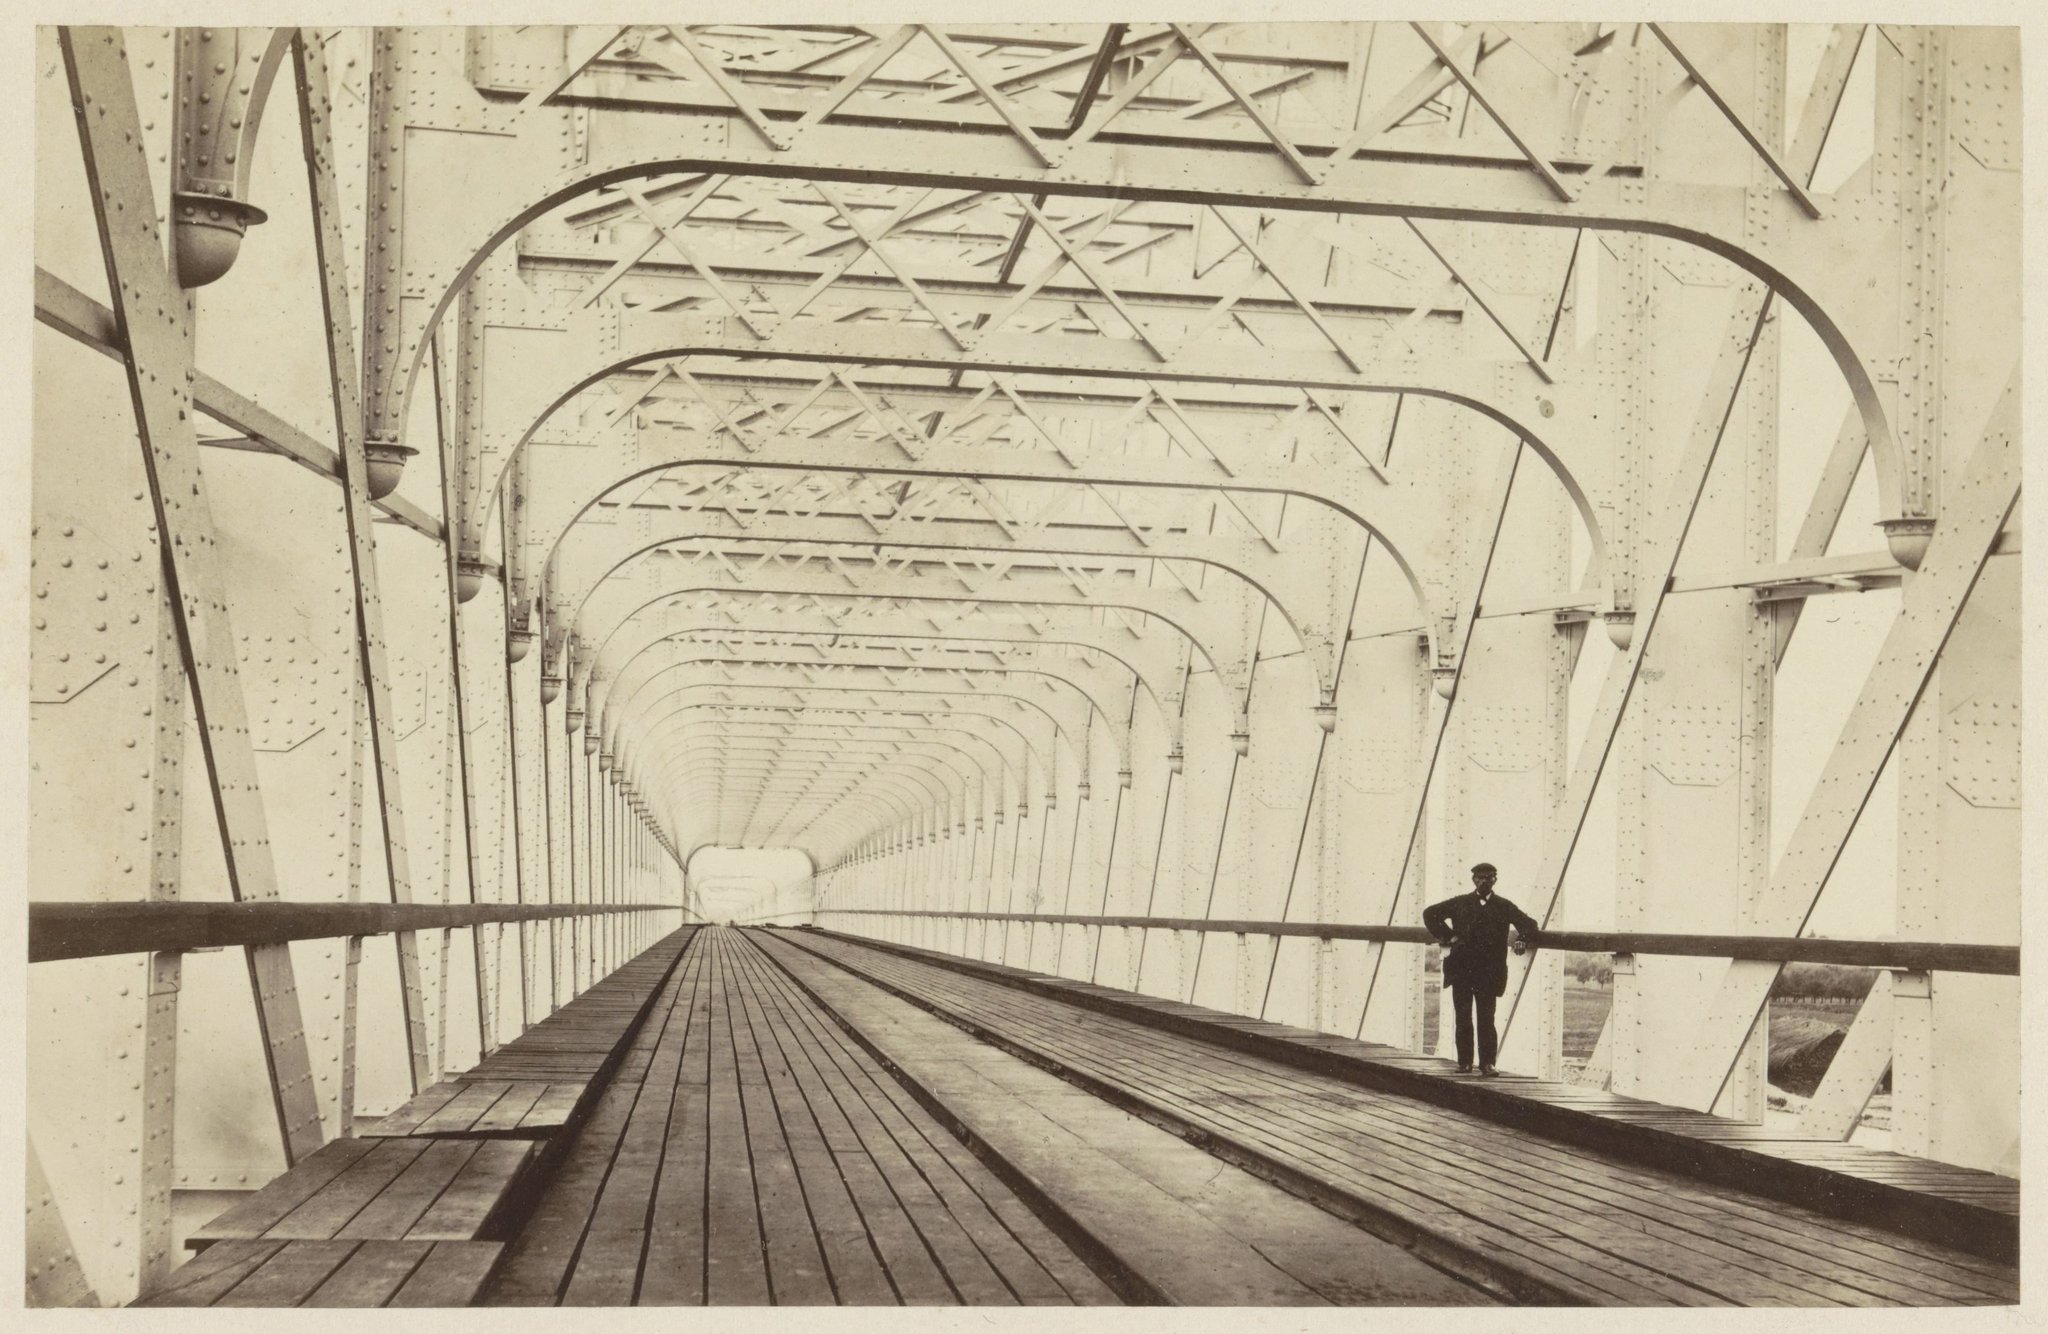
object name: photograph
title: Man op de voltooide brug over de Waal bij Culemborg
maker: pieter oosterhuis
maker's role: draughtsman, print maker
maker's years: 1816-1885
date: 1868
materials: cardboard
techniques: albumen print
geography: culemborg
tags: railway, tramway; rack railway, bridge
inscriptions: label: ‘Met potlood: No. 18; in druk: Spoorwegbrug te Culemborg Uitgave van Blom en Olivierse te Culemborg’